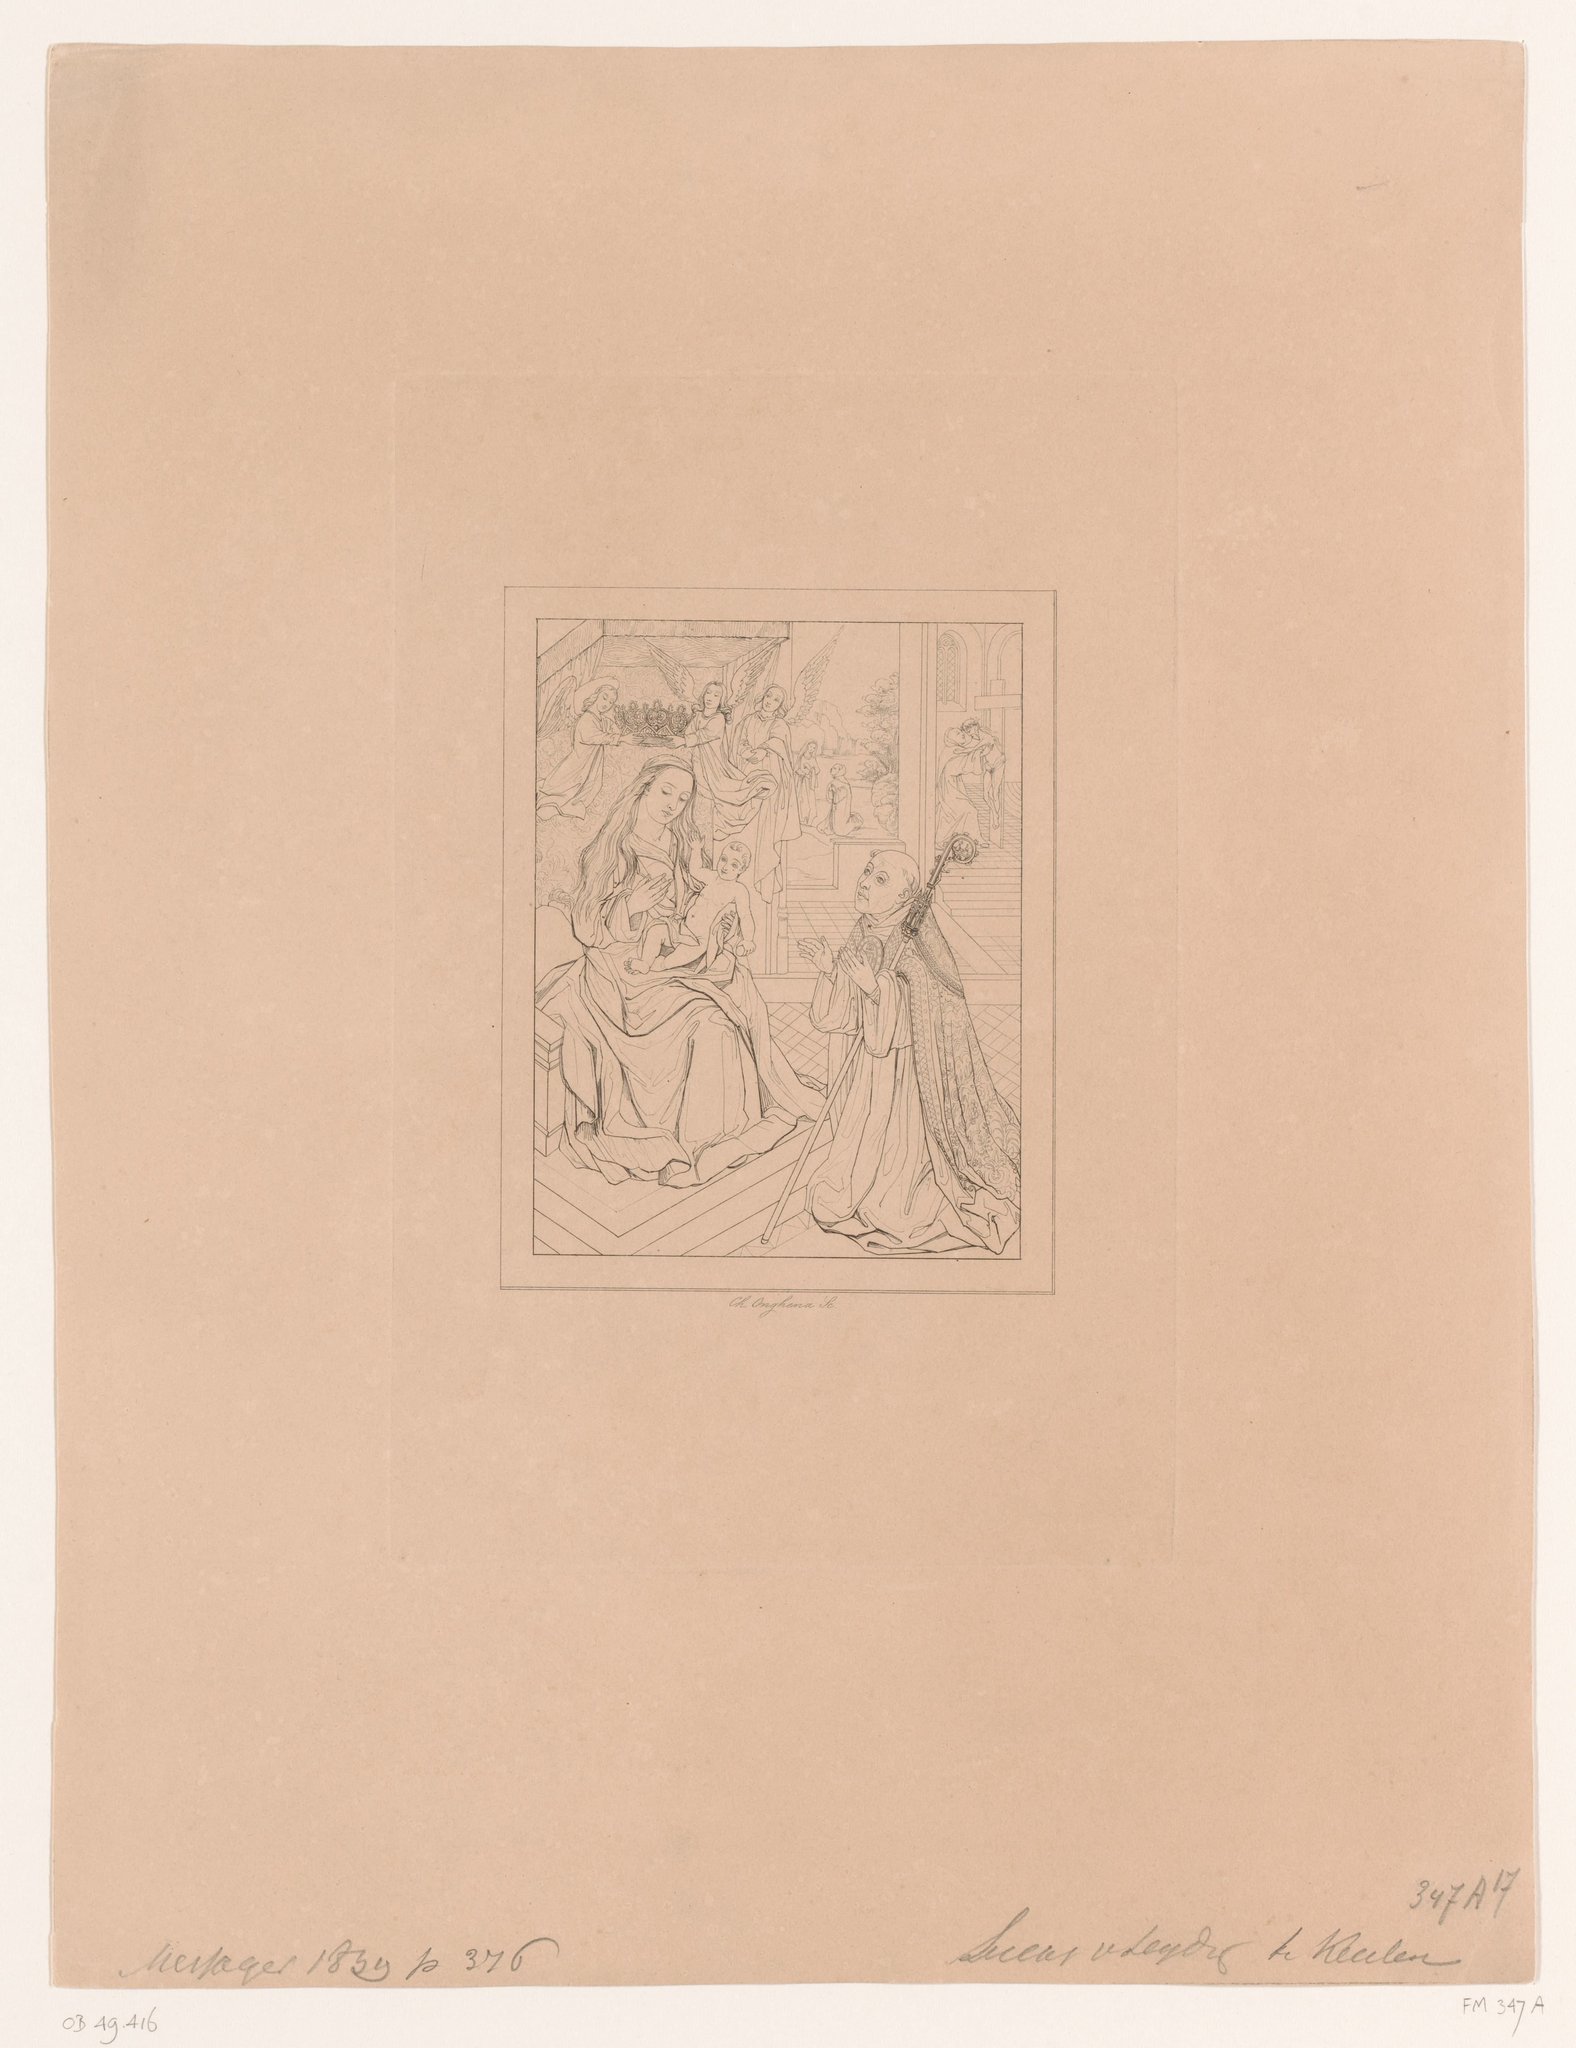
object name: print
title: Bisschop geknield voor Maria met Christus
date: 1839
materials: paper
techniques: etching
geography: ghent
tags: archbishop, bishop, etc. (roman catholic), mary sitting or enthroned, the christ-child sitting on her knee (christ-child to mary's left), picture, painting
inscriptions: collector's mark: Lugt 2228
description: Prent uit: Reiffenberg, F. de, et al. Messager des sciences historiques de Belgique. Gent: Léonard Hebbelynck, 1839, p. 376.